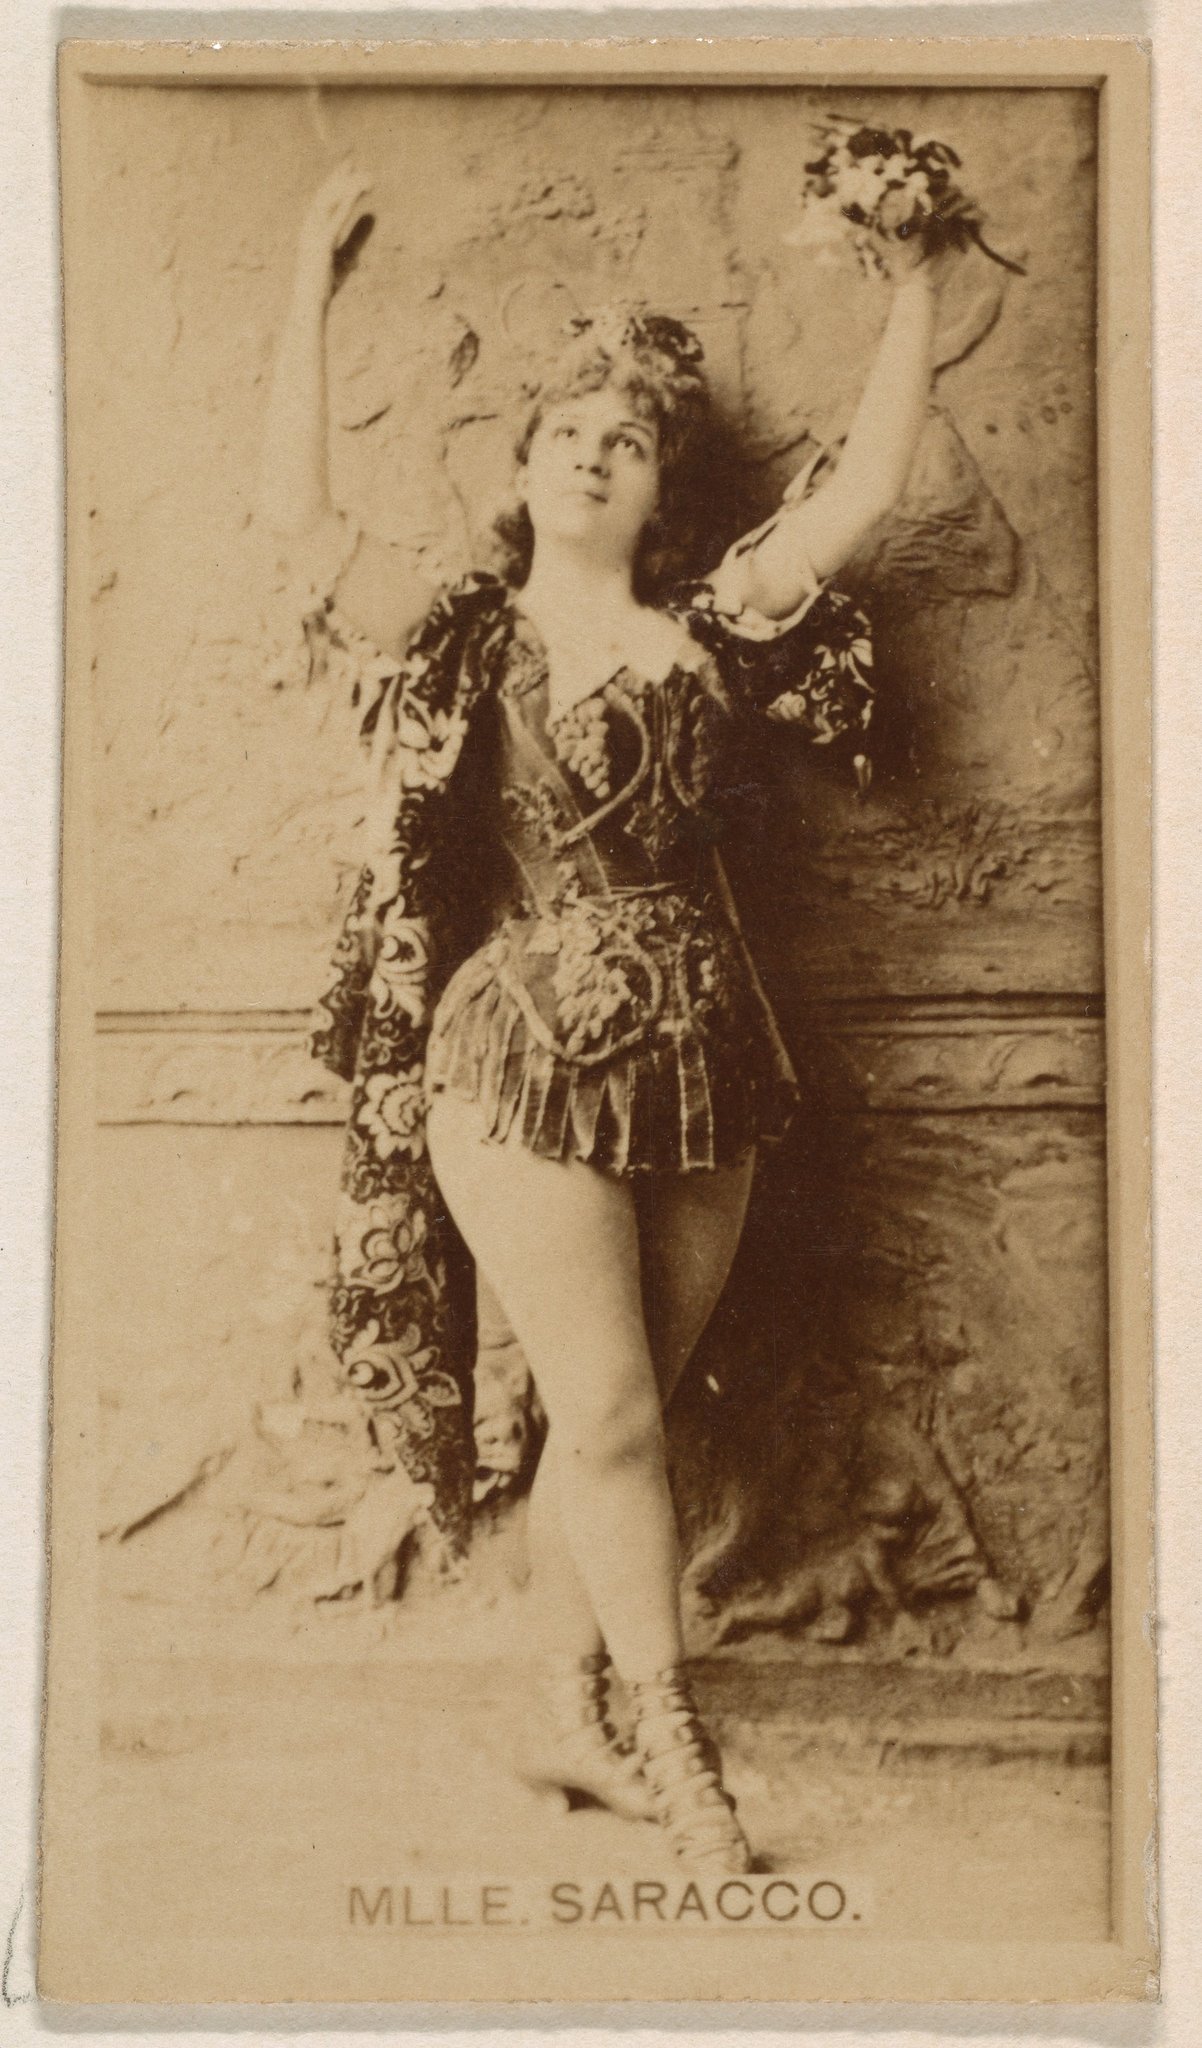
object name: photograph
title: Mlle. Elisa Saracco, from the Actresses series (N245) issued by Kinney Brothers to promote Sweet Caporal Cigarettes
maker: kinney brothers tobacco company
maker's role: publisher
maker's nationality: american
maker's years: 1869-2011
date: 1890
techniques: albumen silver print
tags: portraits,women,actresses